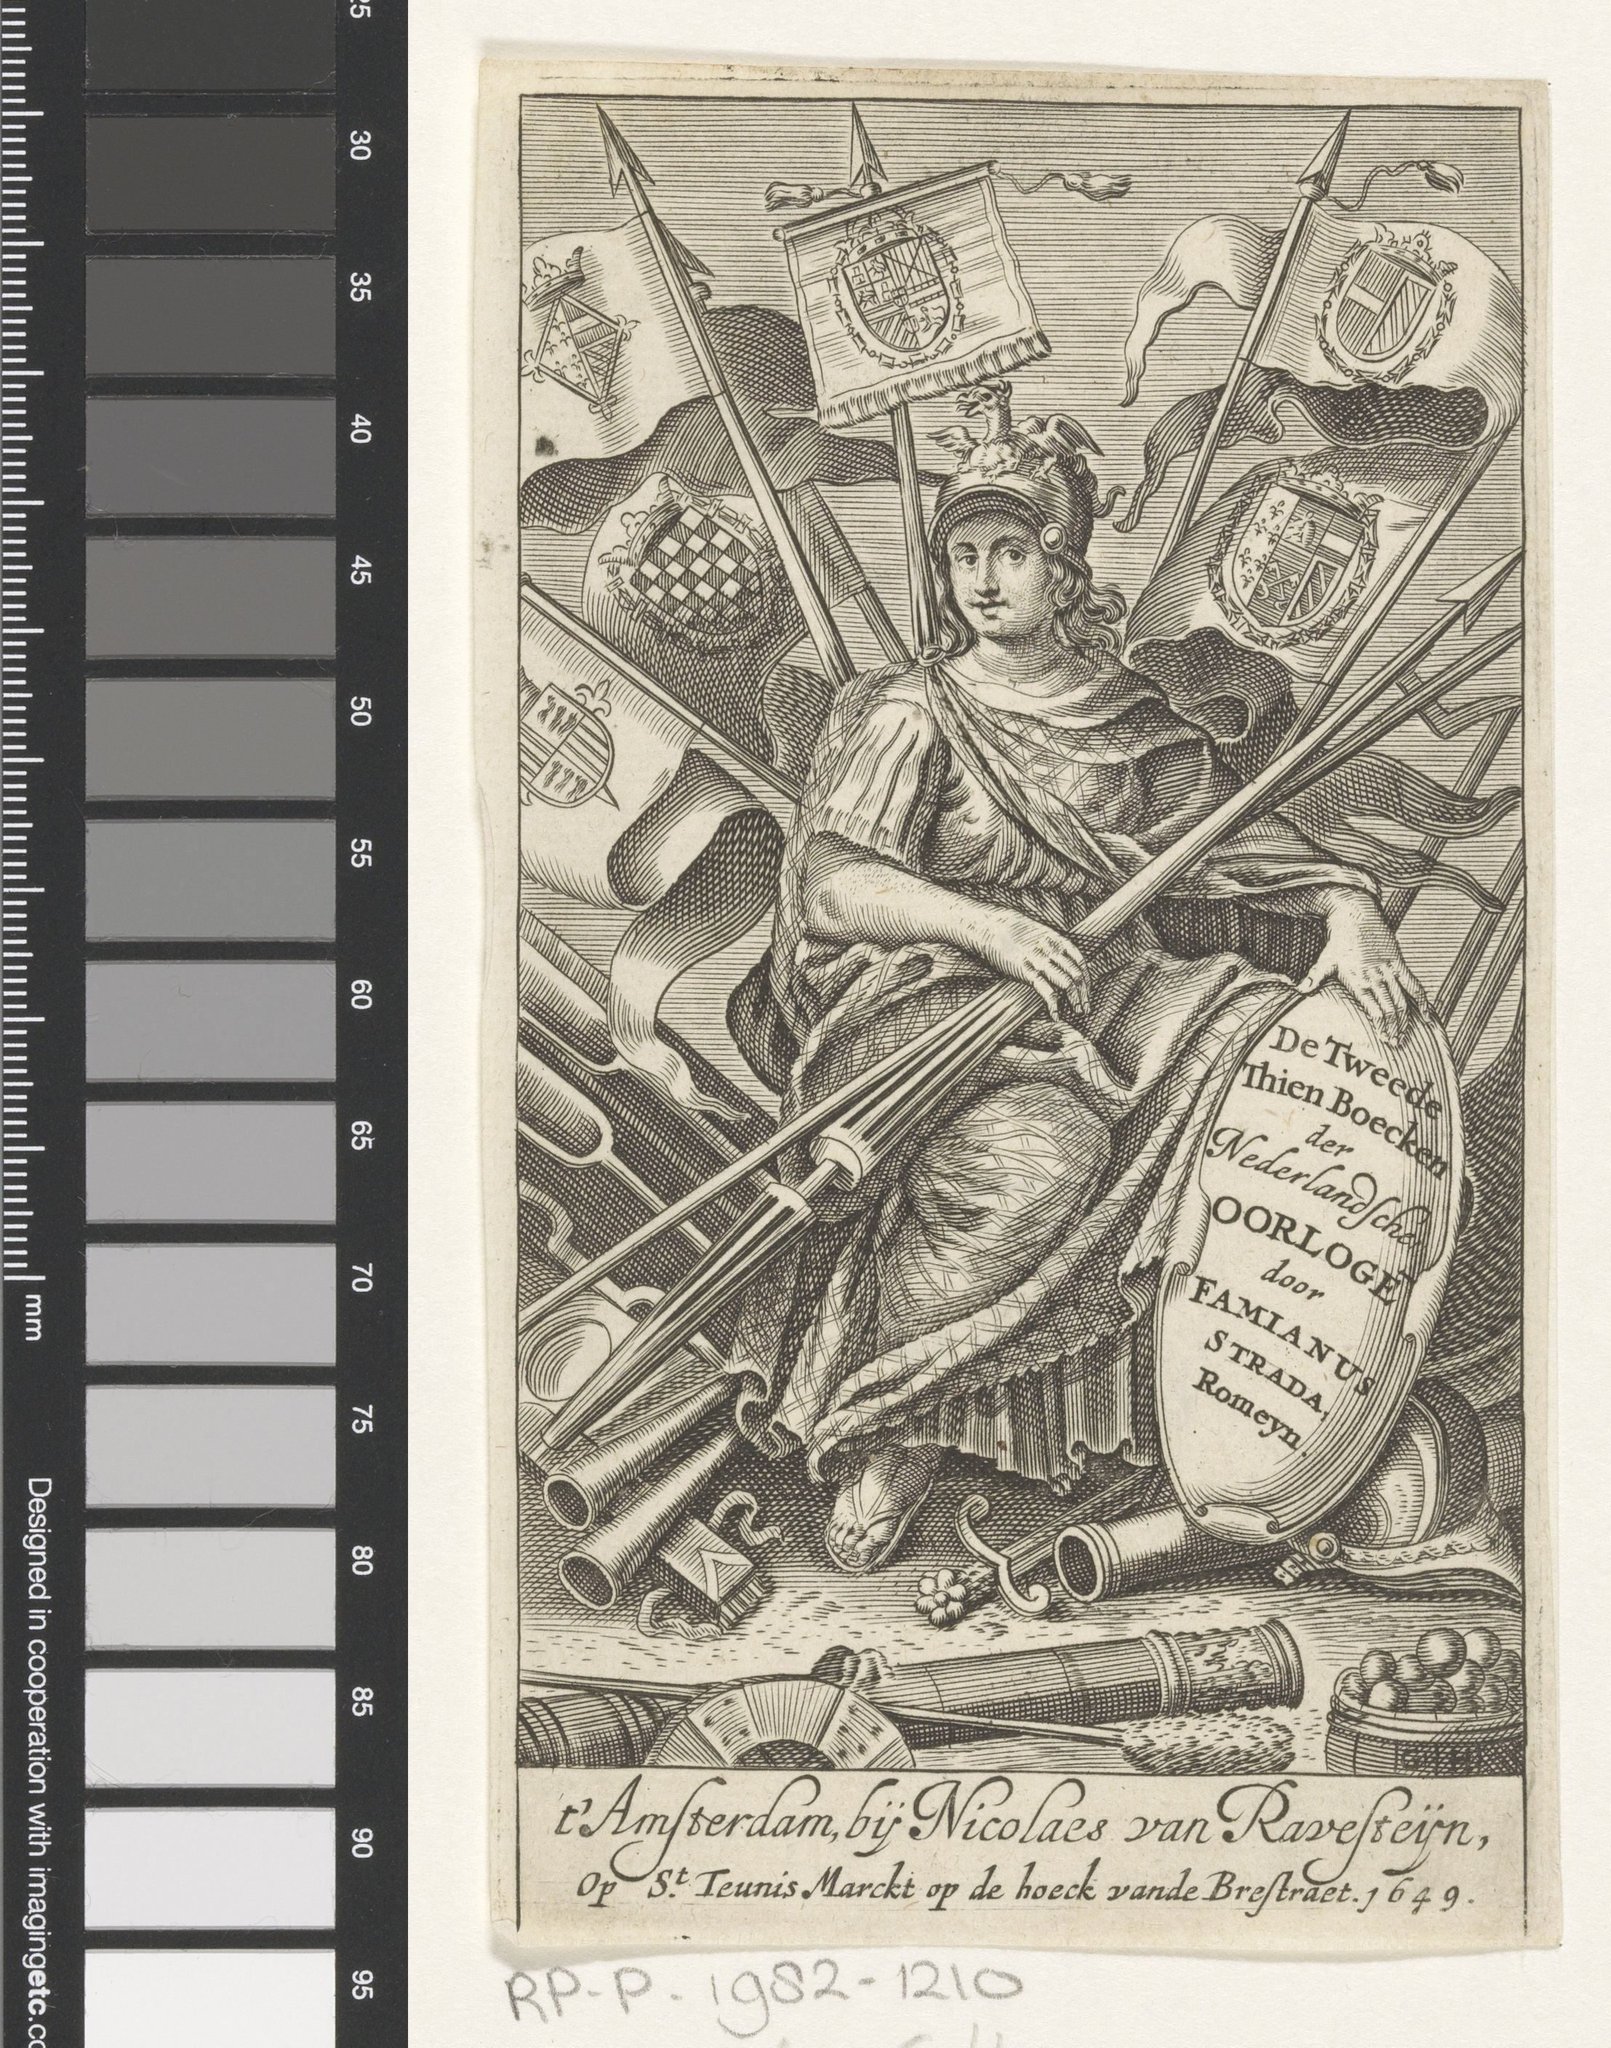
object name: titelblad, titelpagina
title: Vrouwelijke personificatie met vlaggen en wapens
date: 1649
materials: paper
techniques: engraving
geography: amsterdam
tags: sitting figure - aa - female human figure, weapons, (military) flags and standards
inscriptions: collector's mark: Lugt 2760, collector's mark: Lugt 2228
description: Een vrouwelijke personificatie met helm met draak zit te midden van lansen, wapens, een kanon, kogels en vlaggen met wapenschilden. Bij haar een cartouche met de titel van het boek.